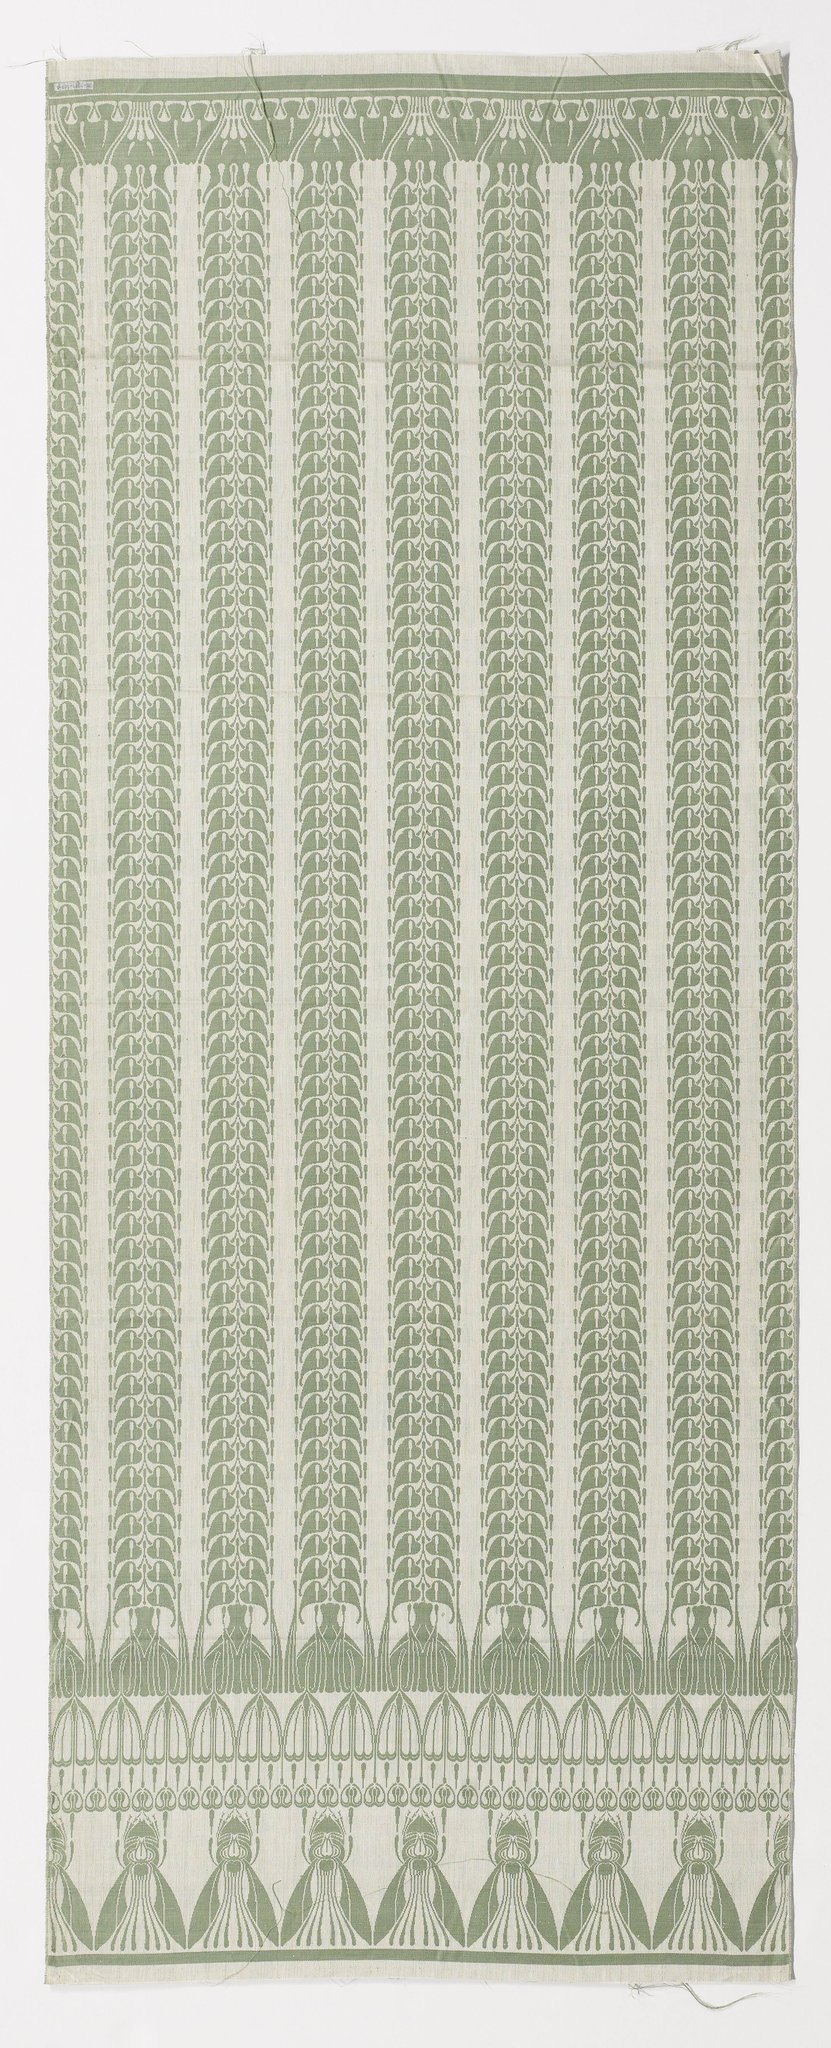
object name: upholstered wall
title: Wandbespanning met dessin van bijen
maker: chris lebeau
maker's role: draughtsman, print maker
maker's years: 1878-1945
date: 1911-1915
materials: linen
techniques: damask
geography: eindhoven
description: Donkerolijfgroene damasten wandbespanning met een dessin van honingbijen